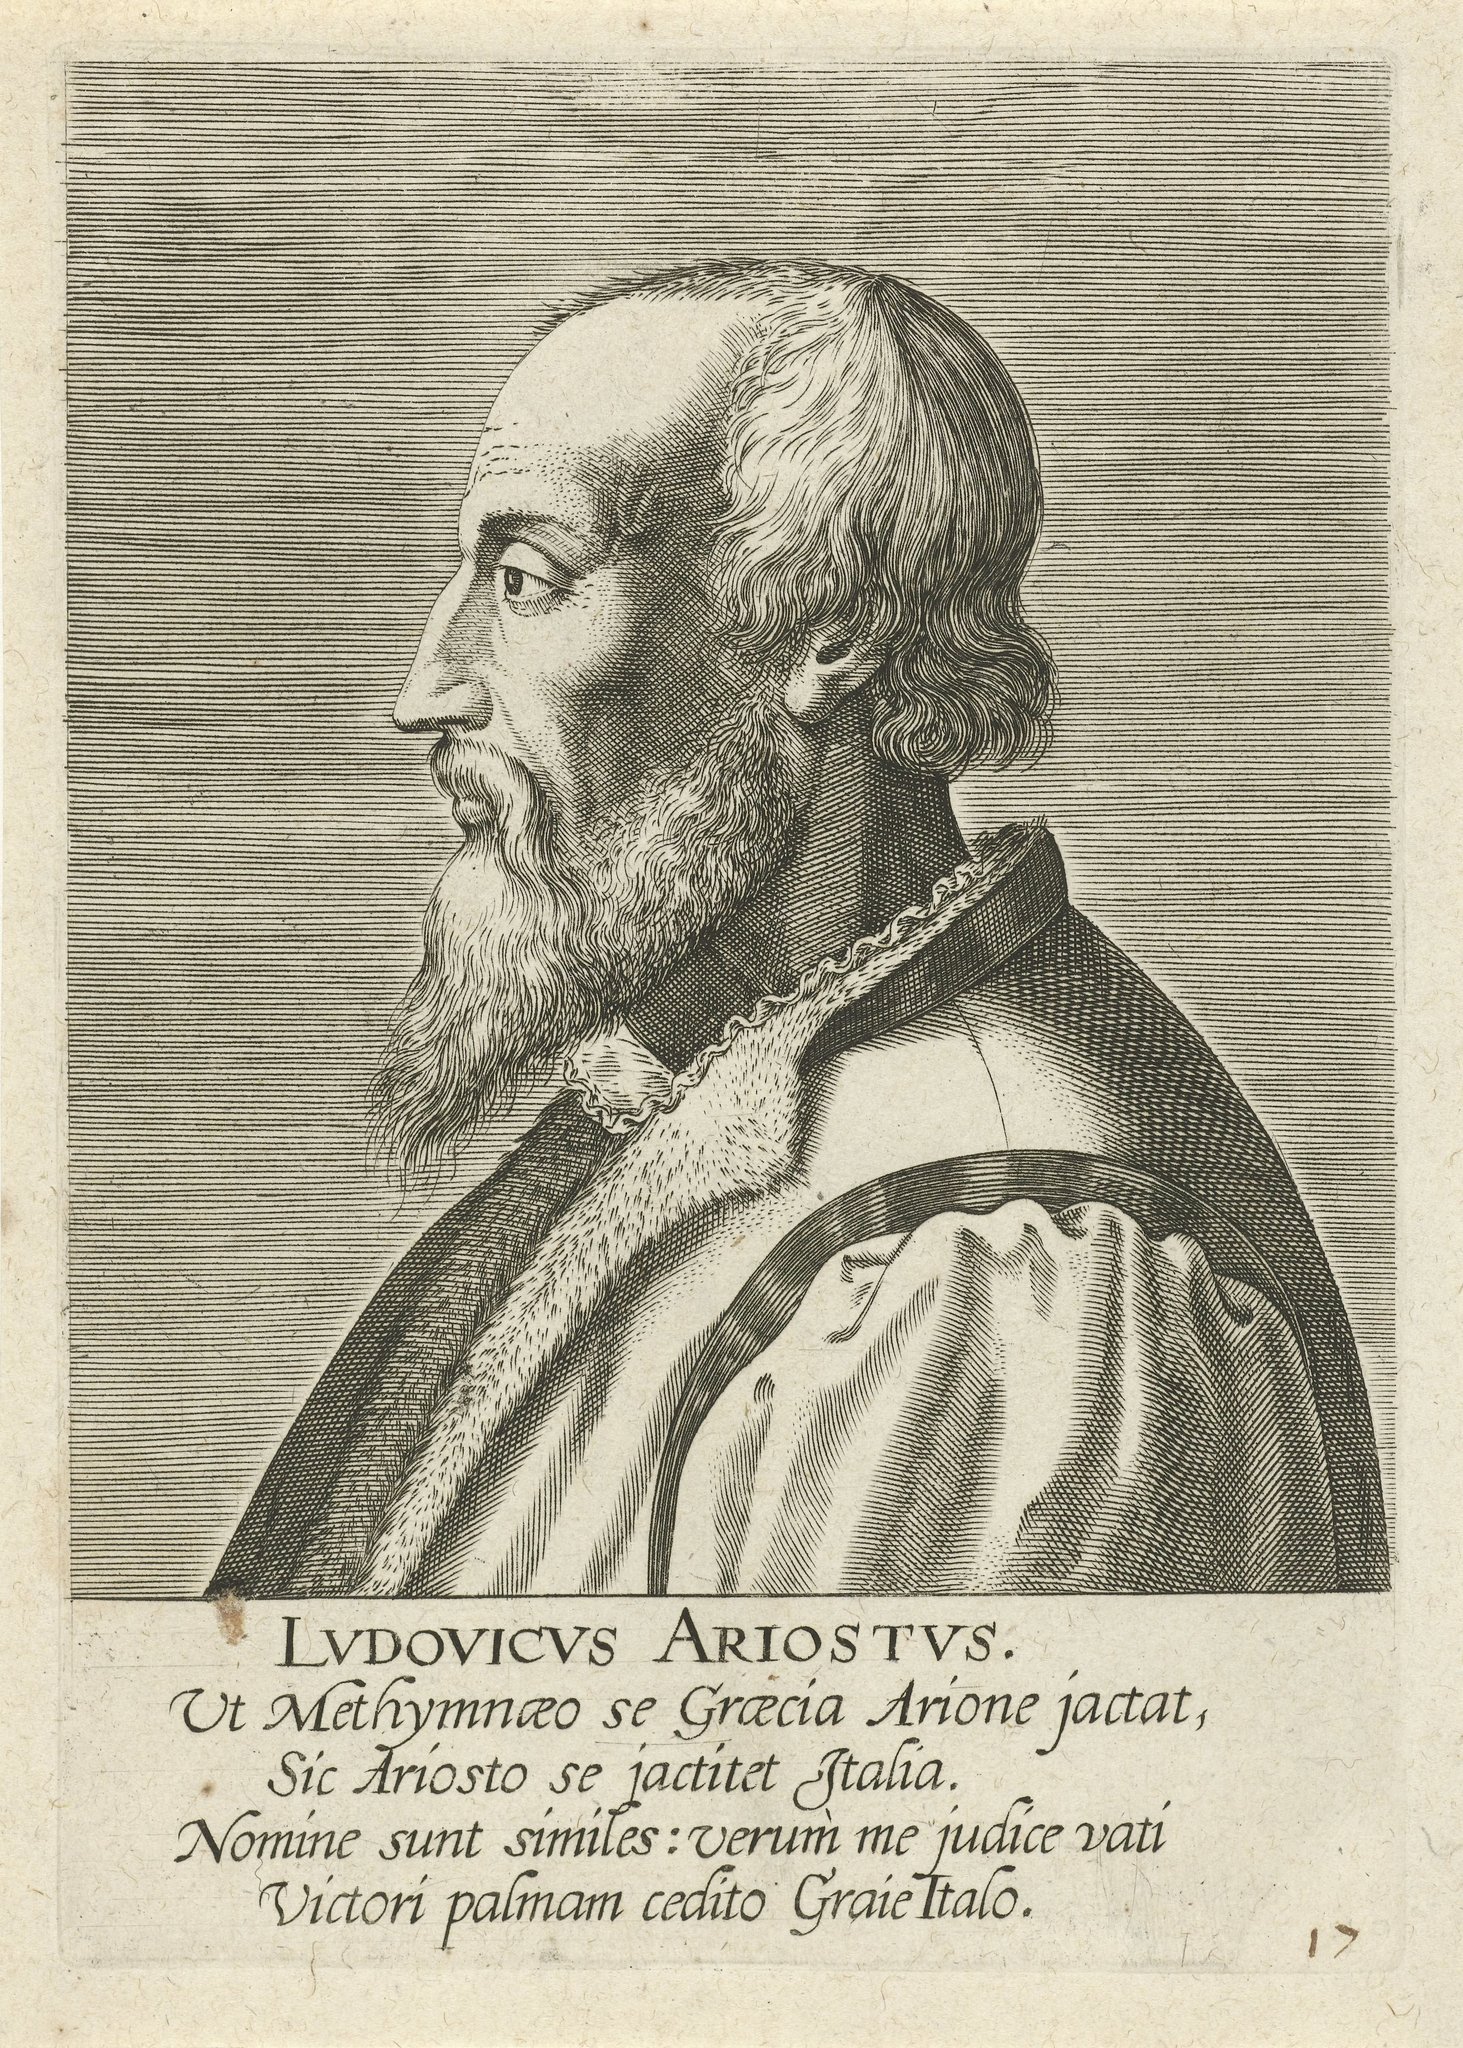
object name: print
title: Lvdovicvs Ariostvs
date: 1587-1612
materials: paper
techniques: engraving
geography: antwerp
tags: reggio, ferrara (stad), schrijver, ludovico aristo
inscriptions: collector's mark: Lugt 2228, number: ‘17’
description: Portret van Ludovico Aristo, dichter aan het hof van Ferrara. In profiel naar links. De prent heeft een Latijns onderschrift.